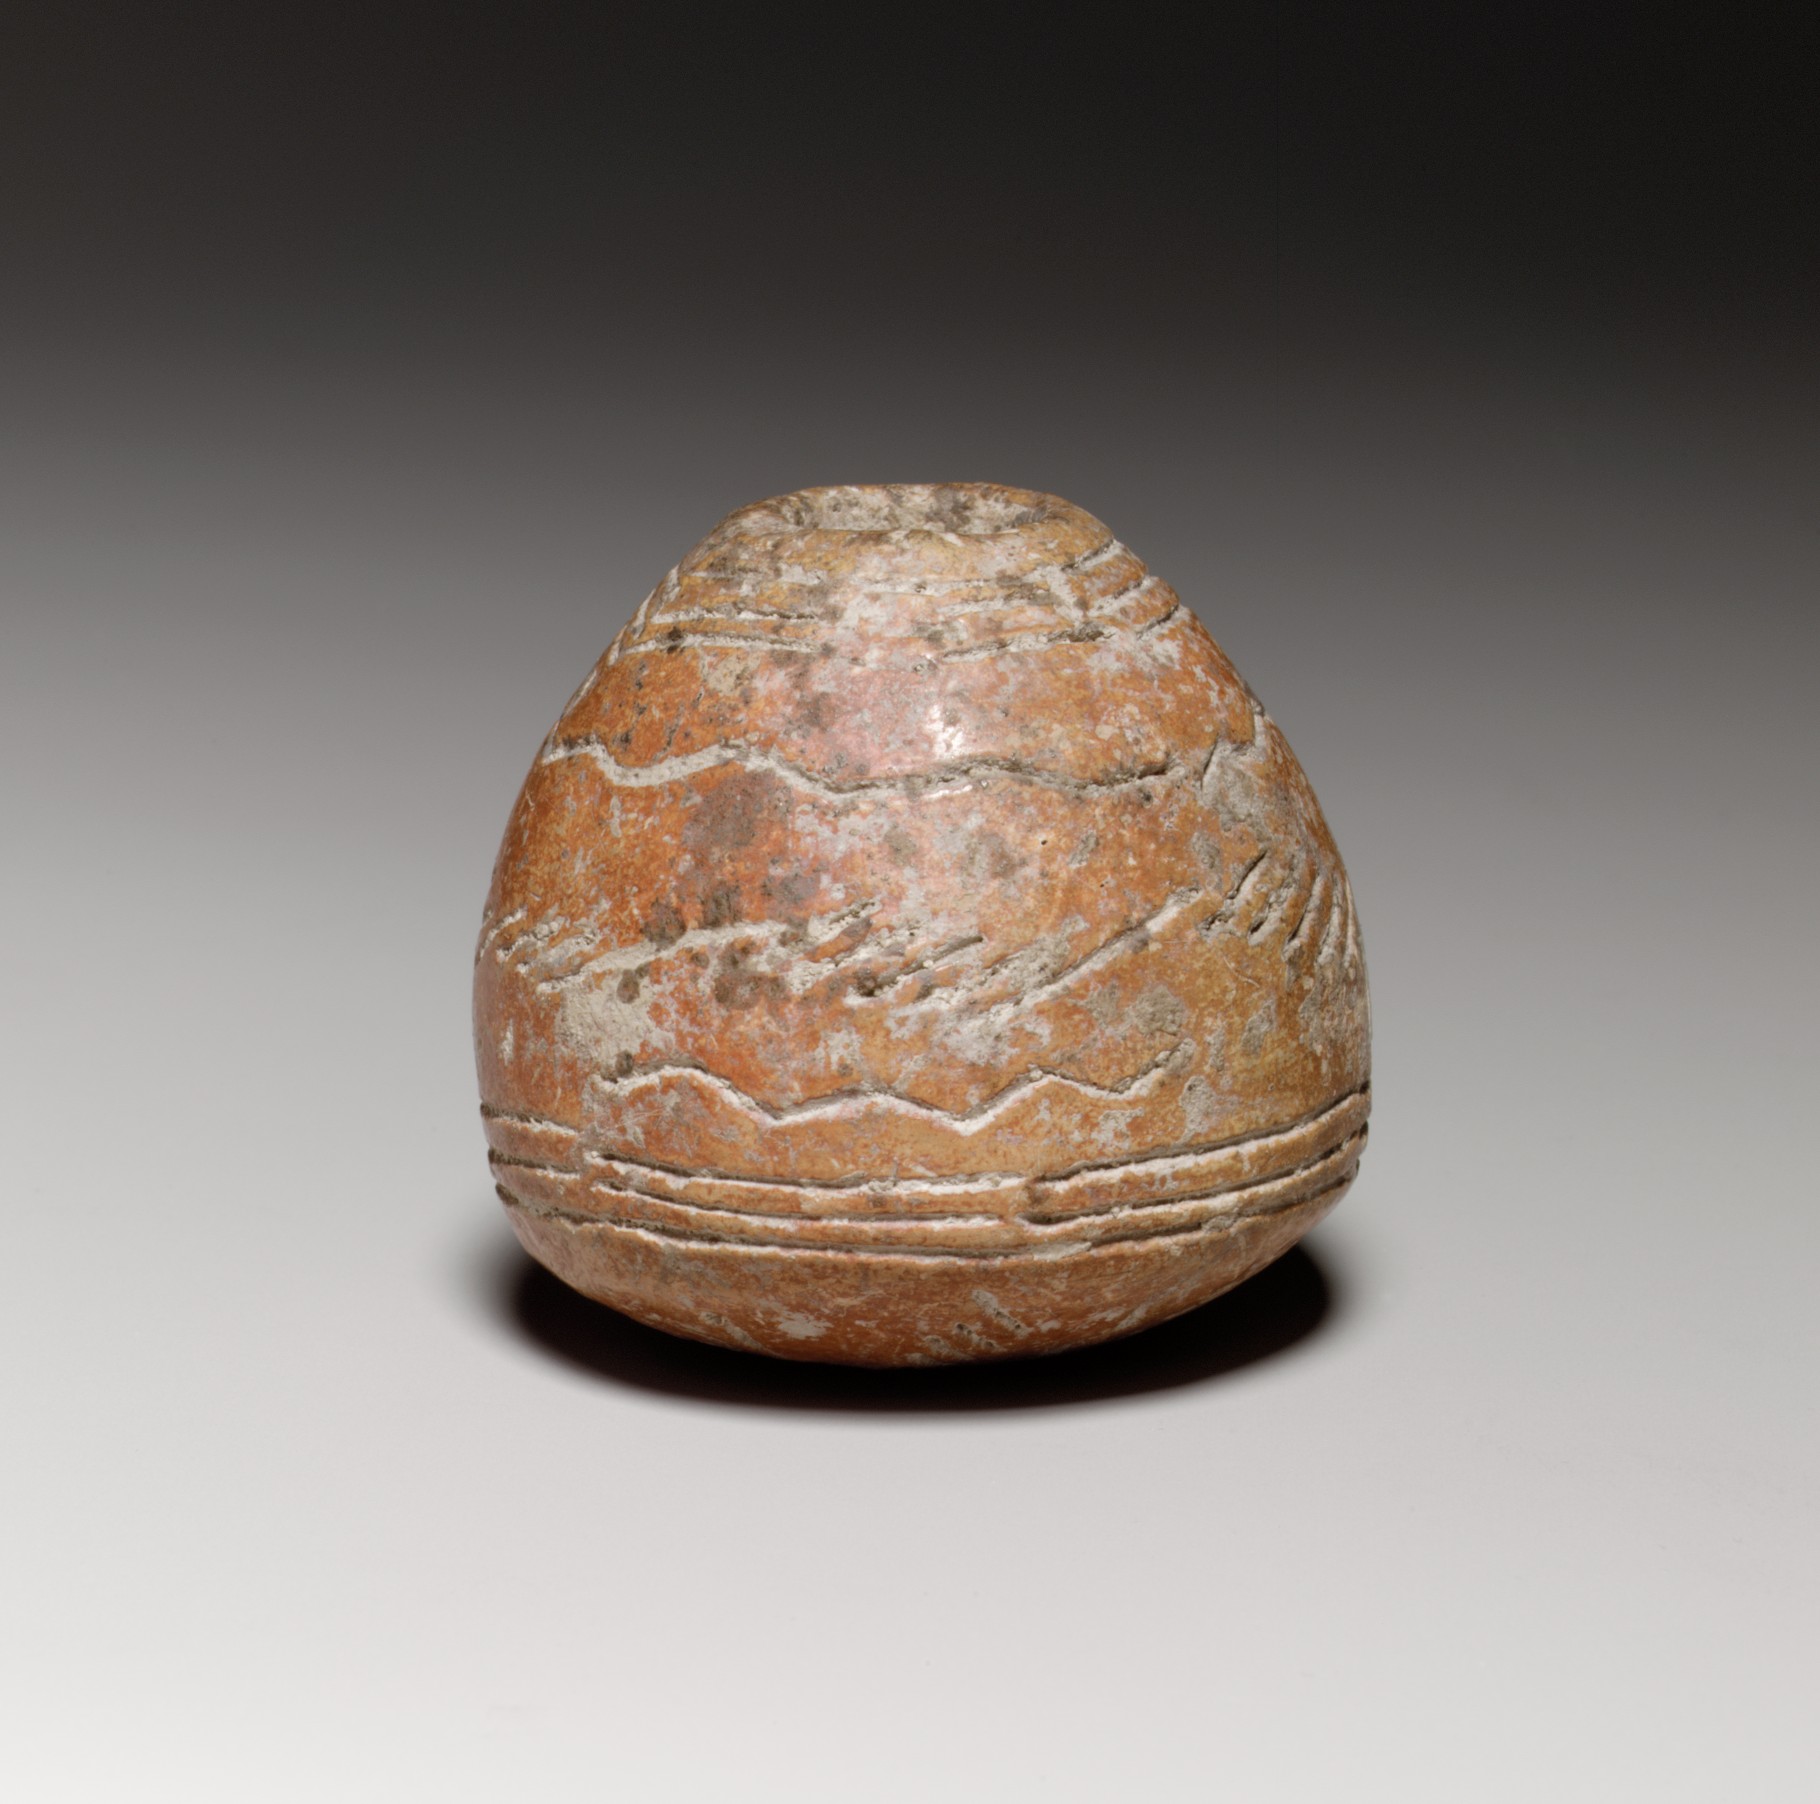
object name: spindle whorl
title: Terracotta conical-hemispherical spindle-whorl with rounded base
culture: cypriot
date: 2000-1725 BCE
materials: terracotta